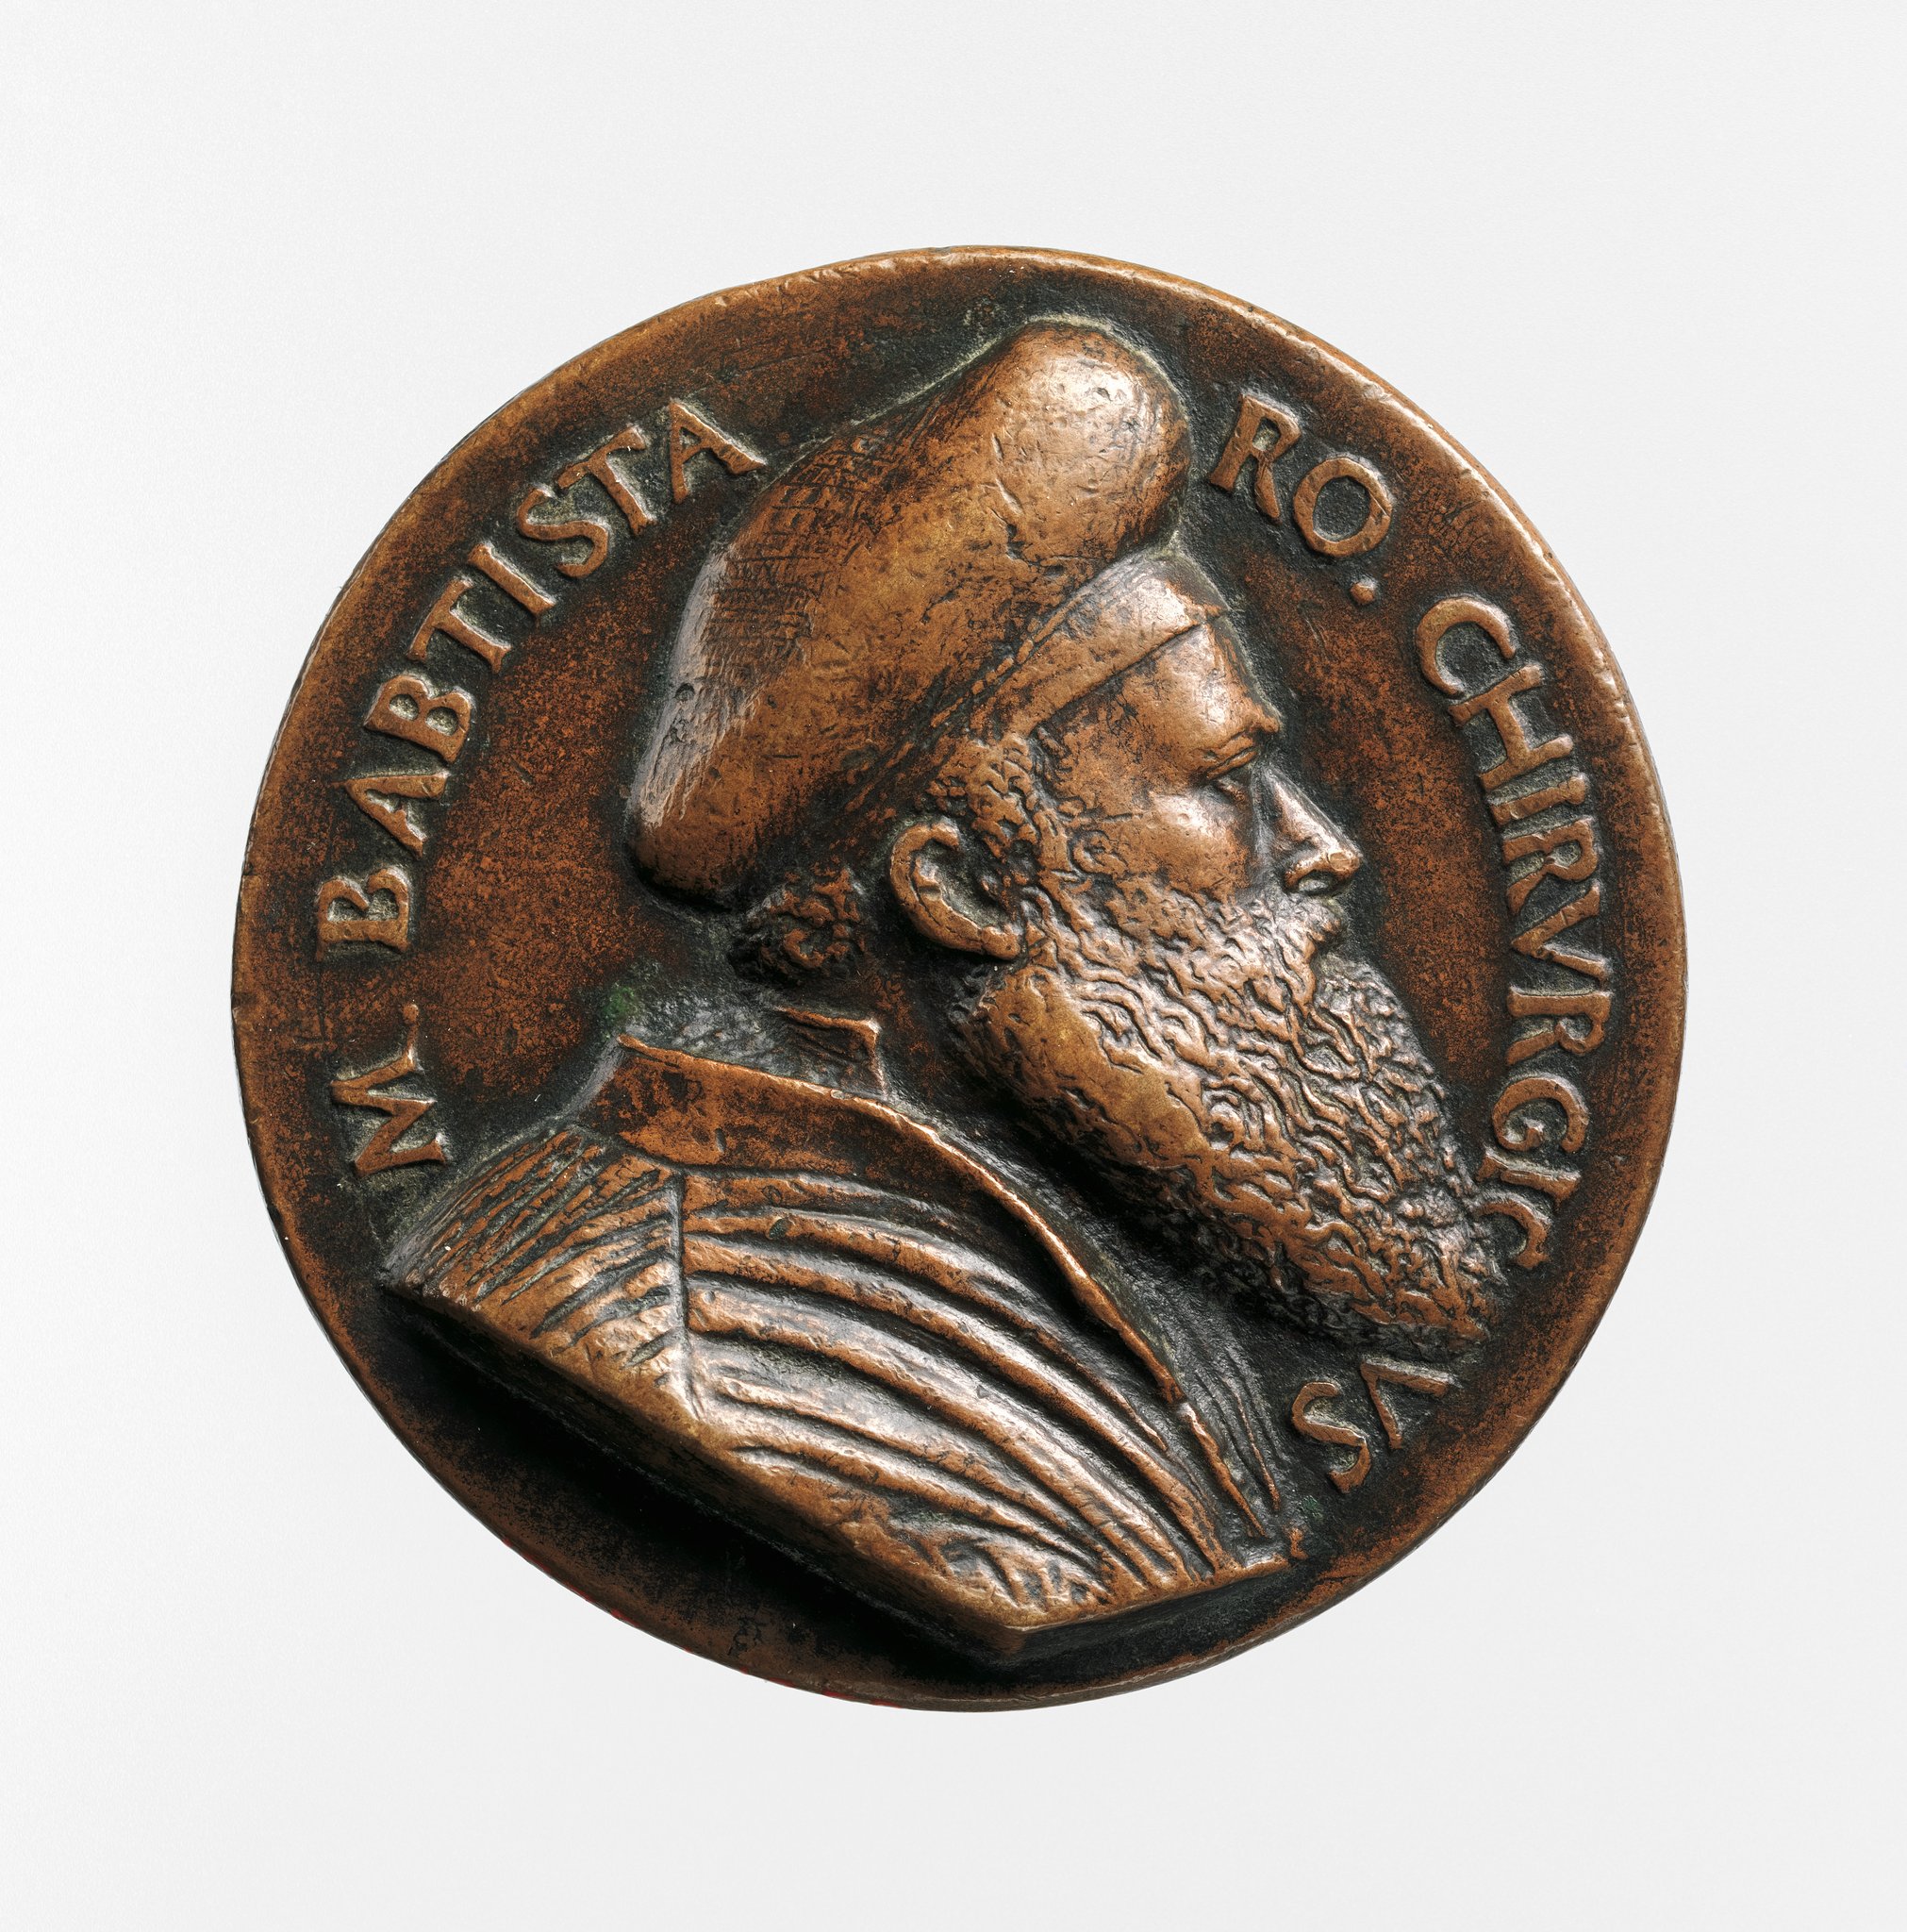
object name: medal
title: Portrait medal of Battista Vigo da Rapallo or Baptista Romanus (obverse); a Hand Holding a Branch and a Surgical Instrument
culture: italian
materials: bronze, copper alloy, lacquer, patina, wax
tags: men,portraits,profiles